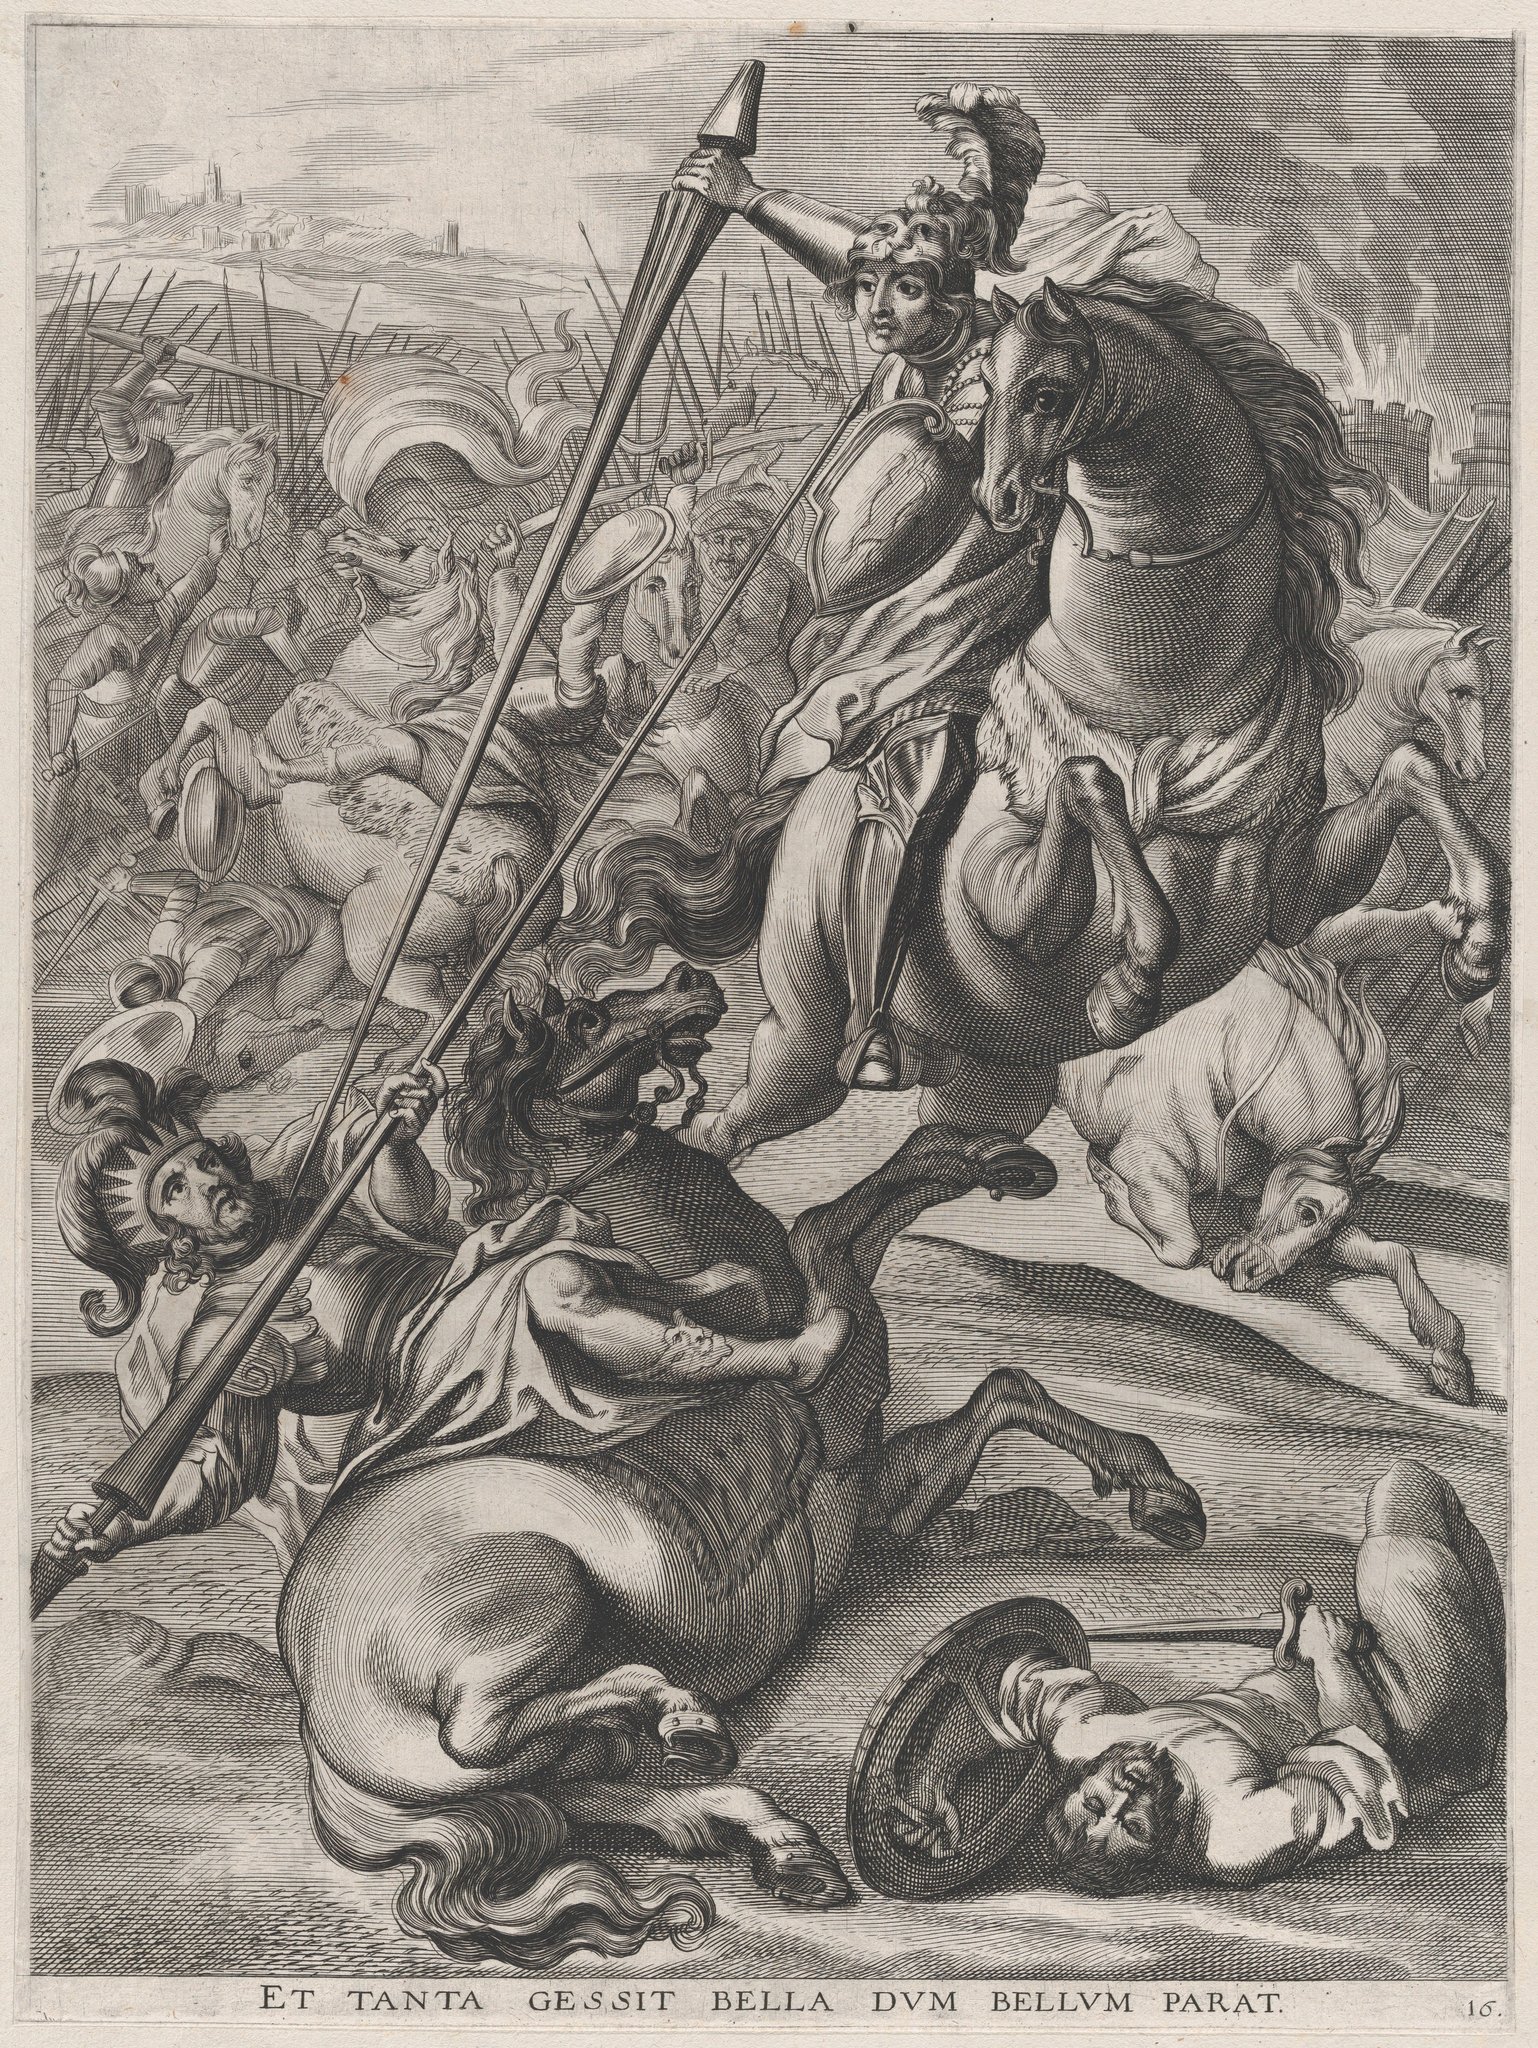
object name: print, fete, ornament architecture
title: Plate 16: Battle of Achilles against the Trojans; from Guillielmus Becanus's 'Serenissimi Principis Ferdinandi, Hispaniarum Infantis...'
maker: johannes meursius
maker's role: publisher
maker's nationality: flemish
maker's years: 1600-1699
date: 1636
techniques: engraving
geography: antwerp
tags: battles,weapons,men,achilles,horses